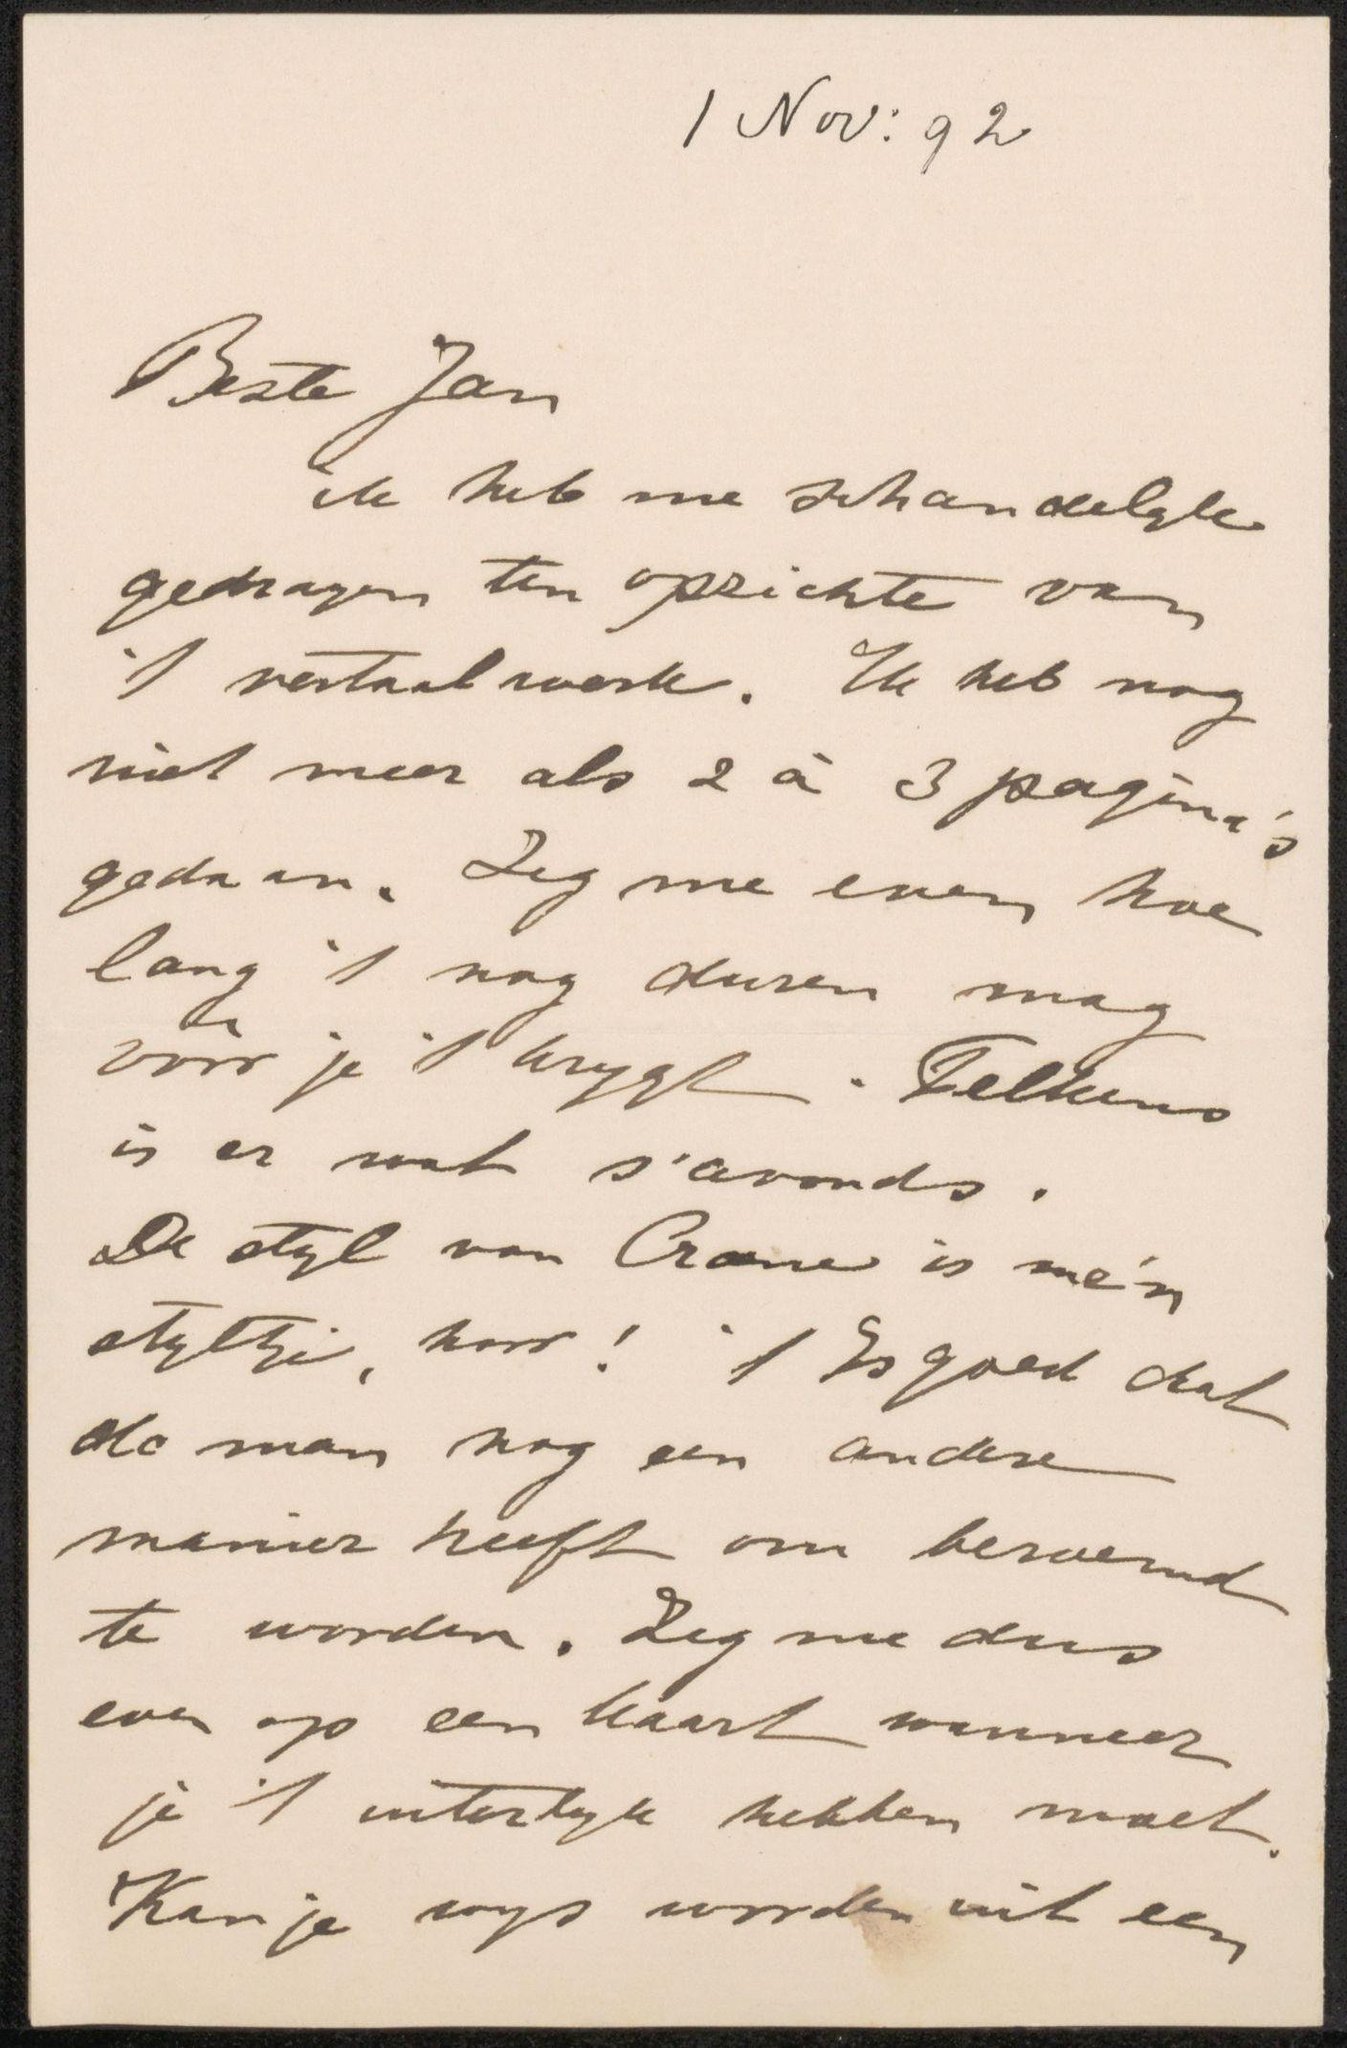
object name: letter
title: Brief aan Jan Veth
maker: wally moes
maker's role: draughtsman, print maker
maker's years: 1856-1918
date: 1874-1918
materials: ink, paper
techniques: pen, writing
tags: dordrecht, painter, designer, jan veth, liverpool, london, print maker, draughtsman, walter crane, drawing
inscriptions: collector's mark: ‘RPK’, watermark